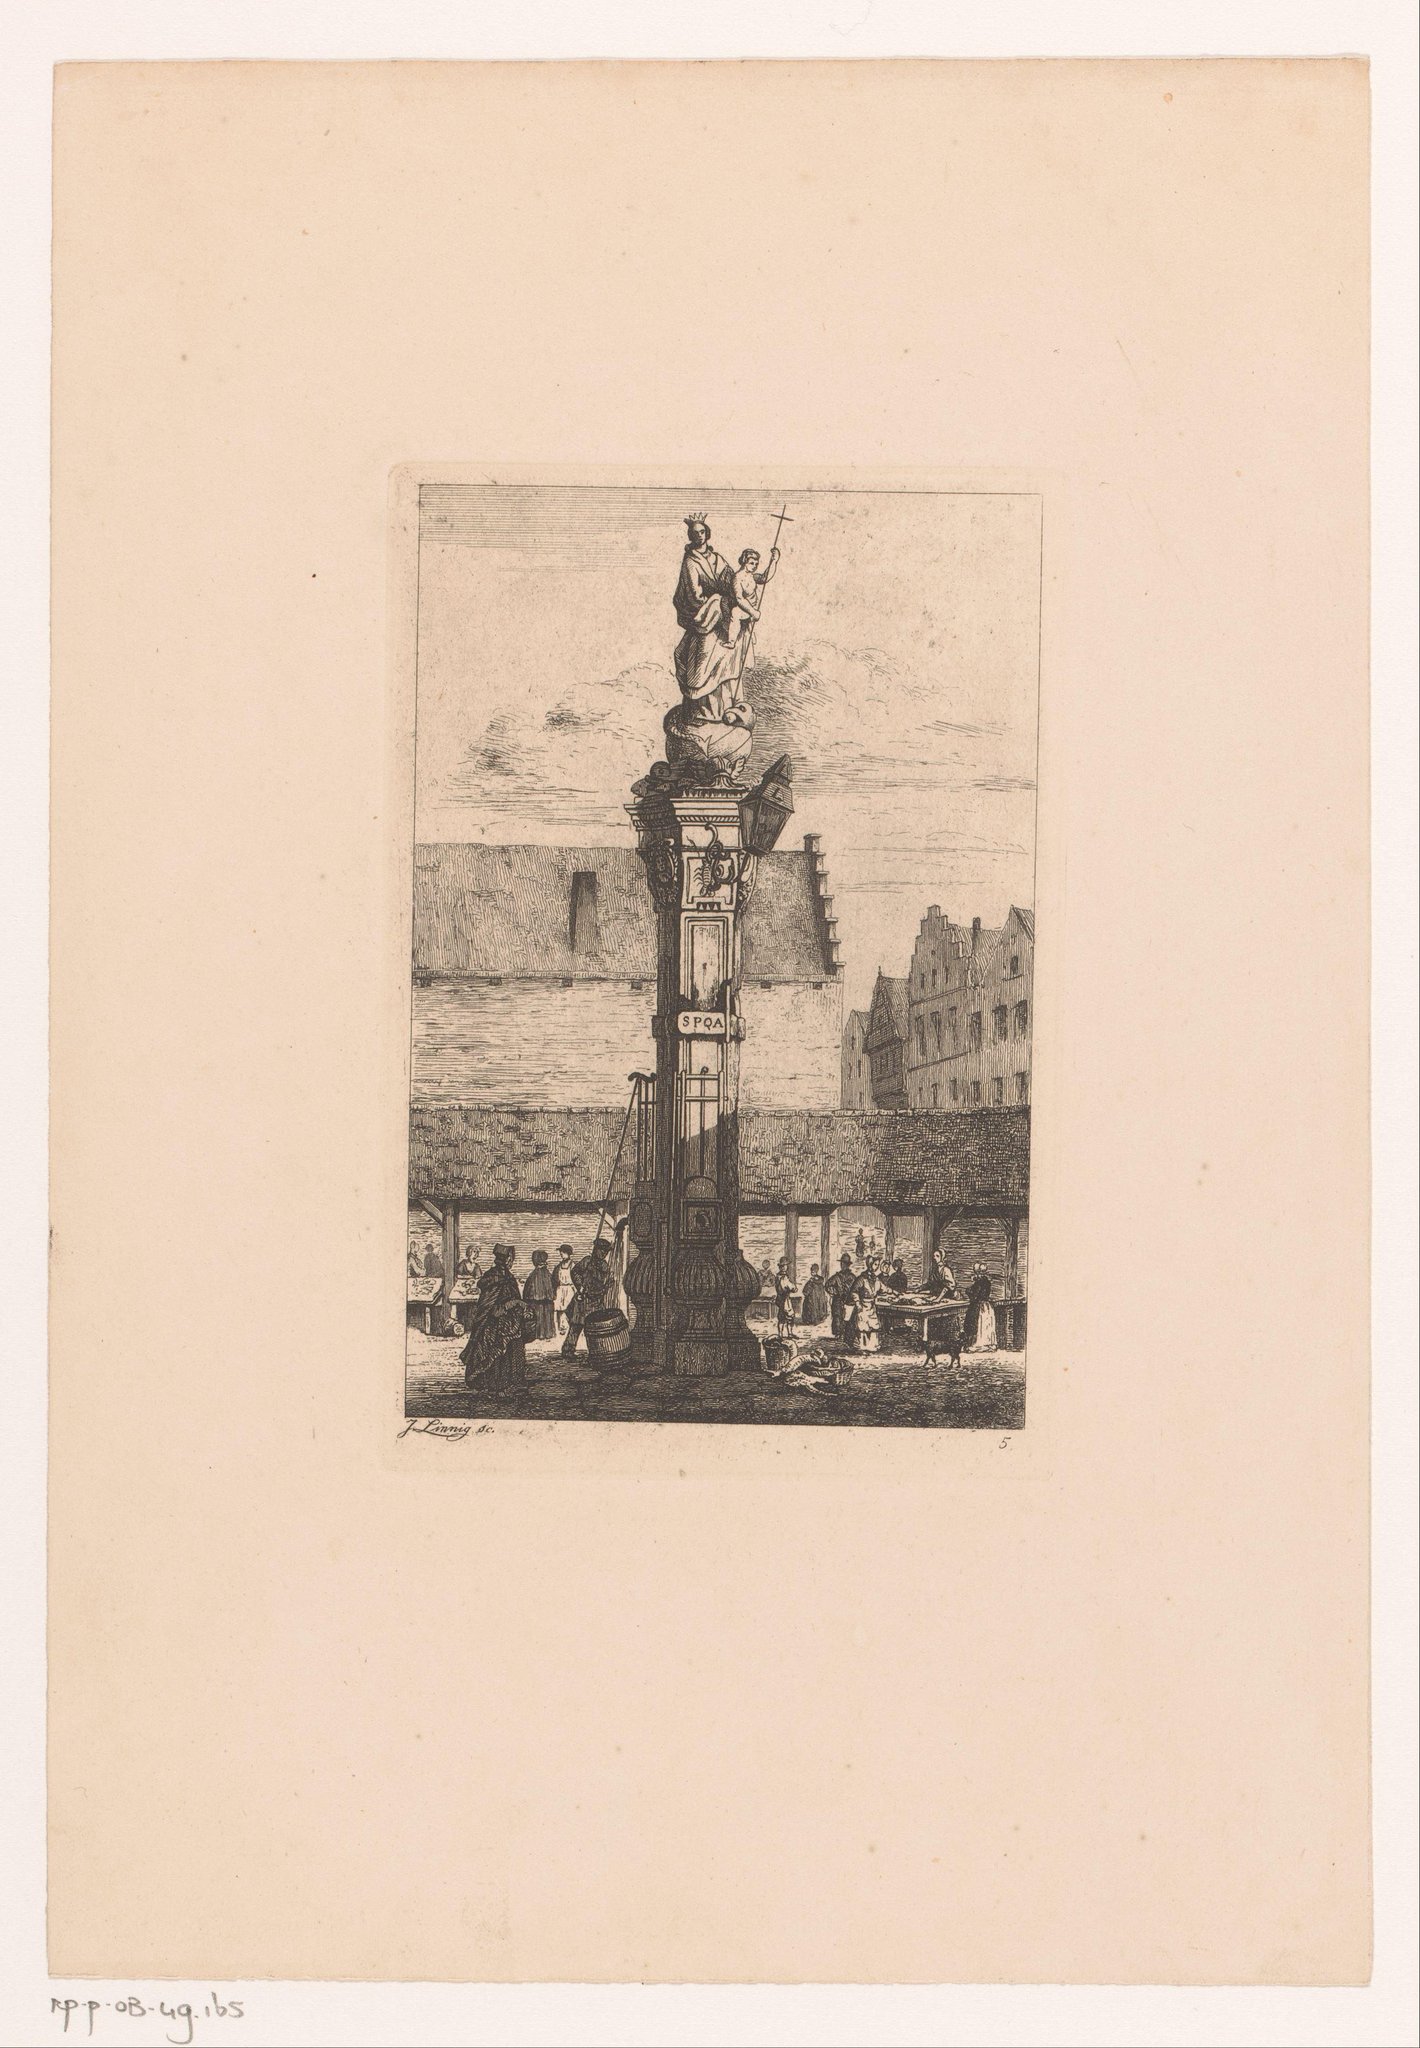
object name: book illustration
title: Fontein op de Oude Vismarkt in Antwerpen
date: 1868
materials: paper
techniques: etching, intaglio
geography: antwerp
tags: ornamental fountain, antwerp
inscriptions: annotation: Lugt 2228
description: Prent uit: Mertens, F.H. Album historique de la ville d'Anvers [...]. Antwerpen: J.E. Buschmann, 1868.